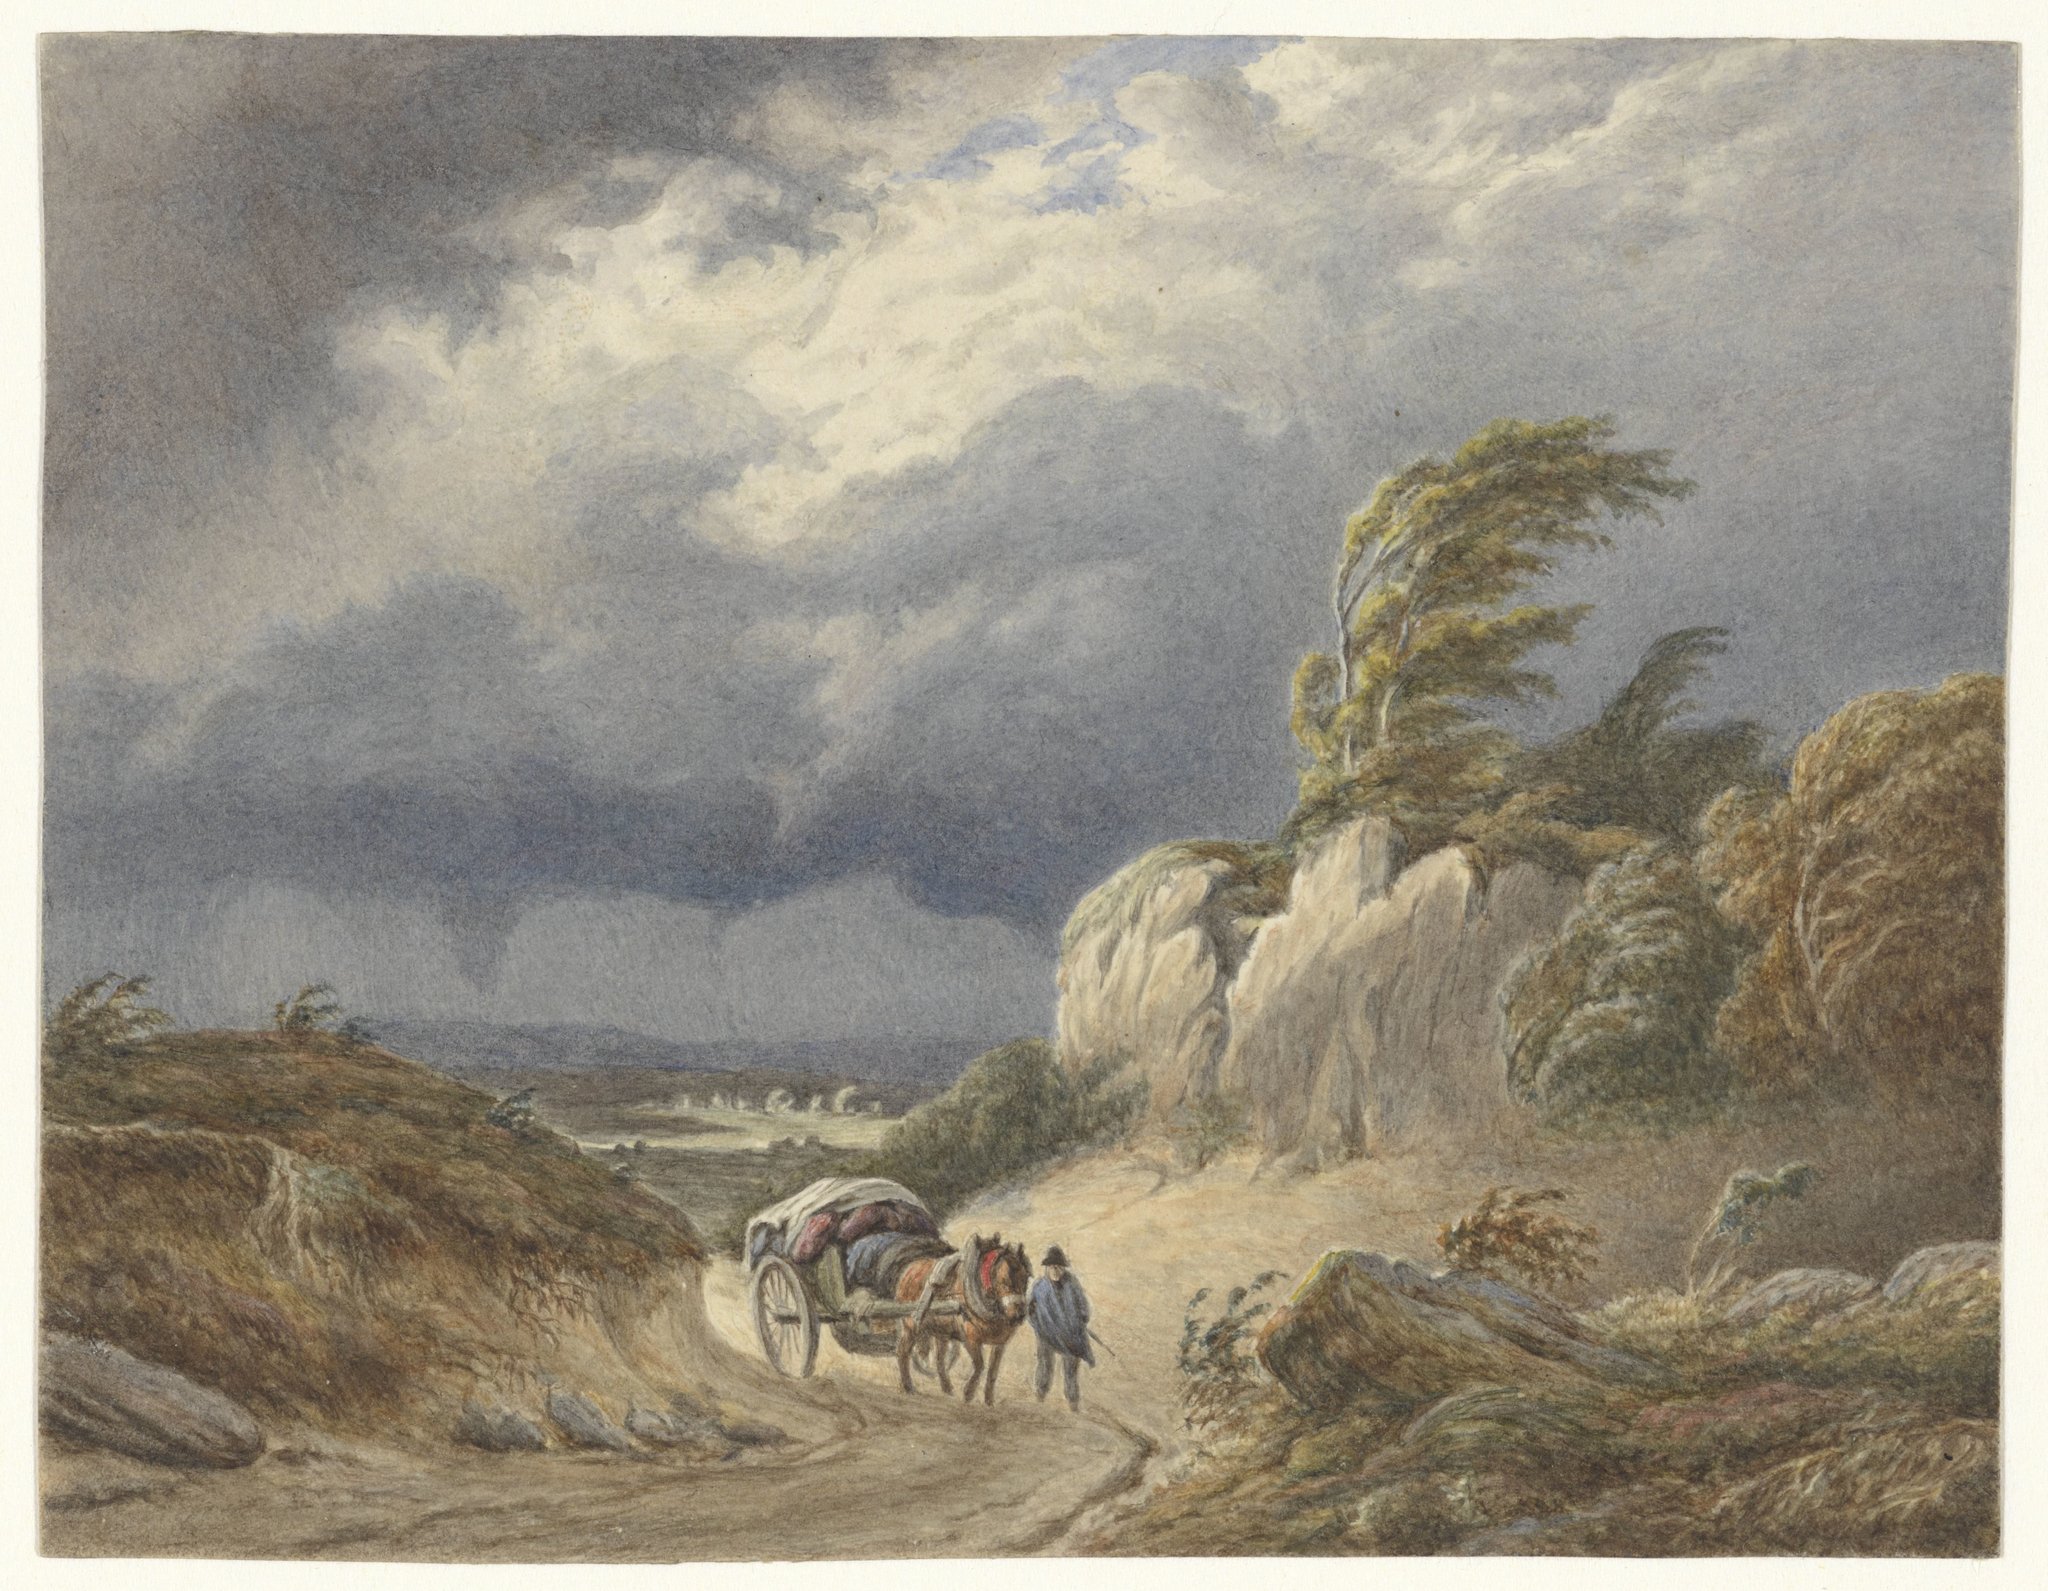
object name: drawing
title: Landschap met naderende storm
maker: matthijs maris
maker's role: draughtsman, painter, print maker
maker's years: 1839-1917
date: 1849-1917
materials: paper, watercolor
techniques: brush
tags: storm